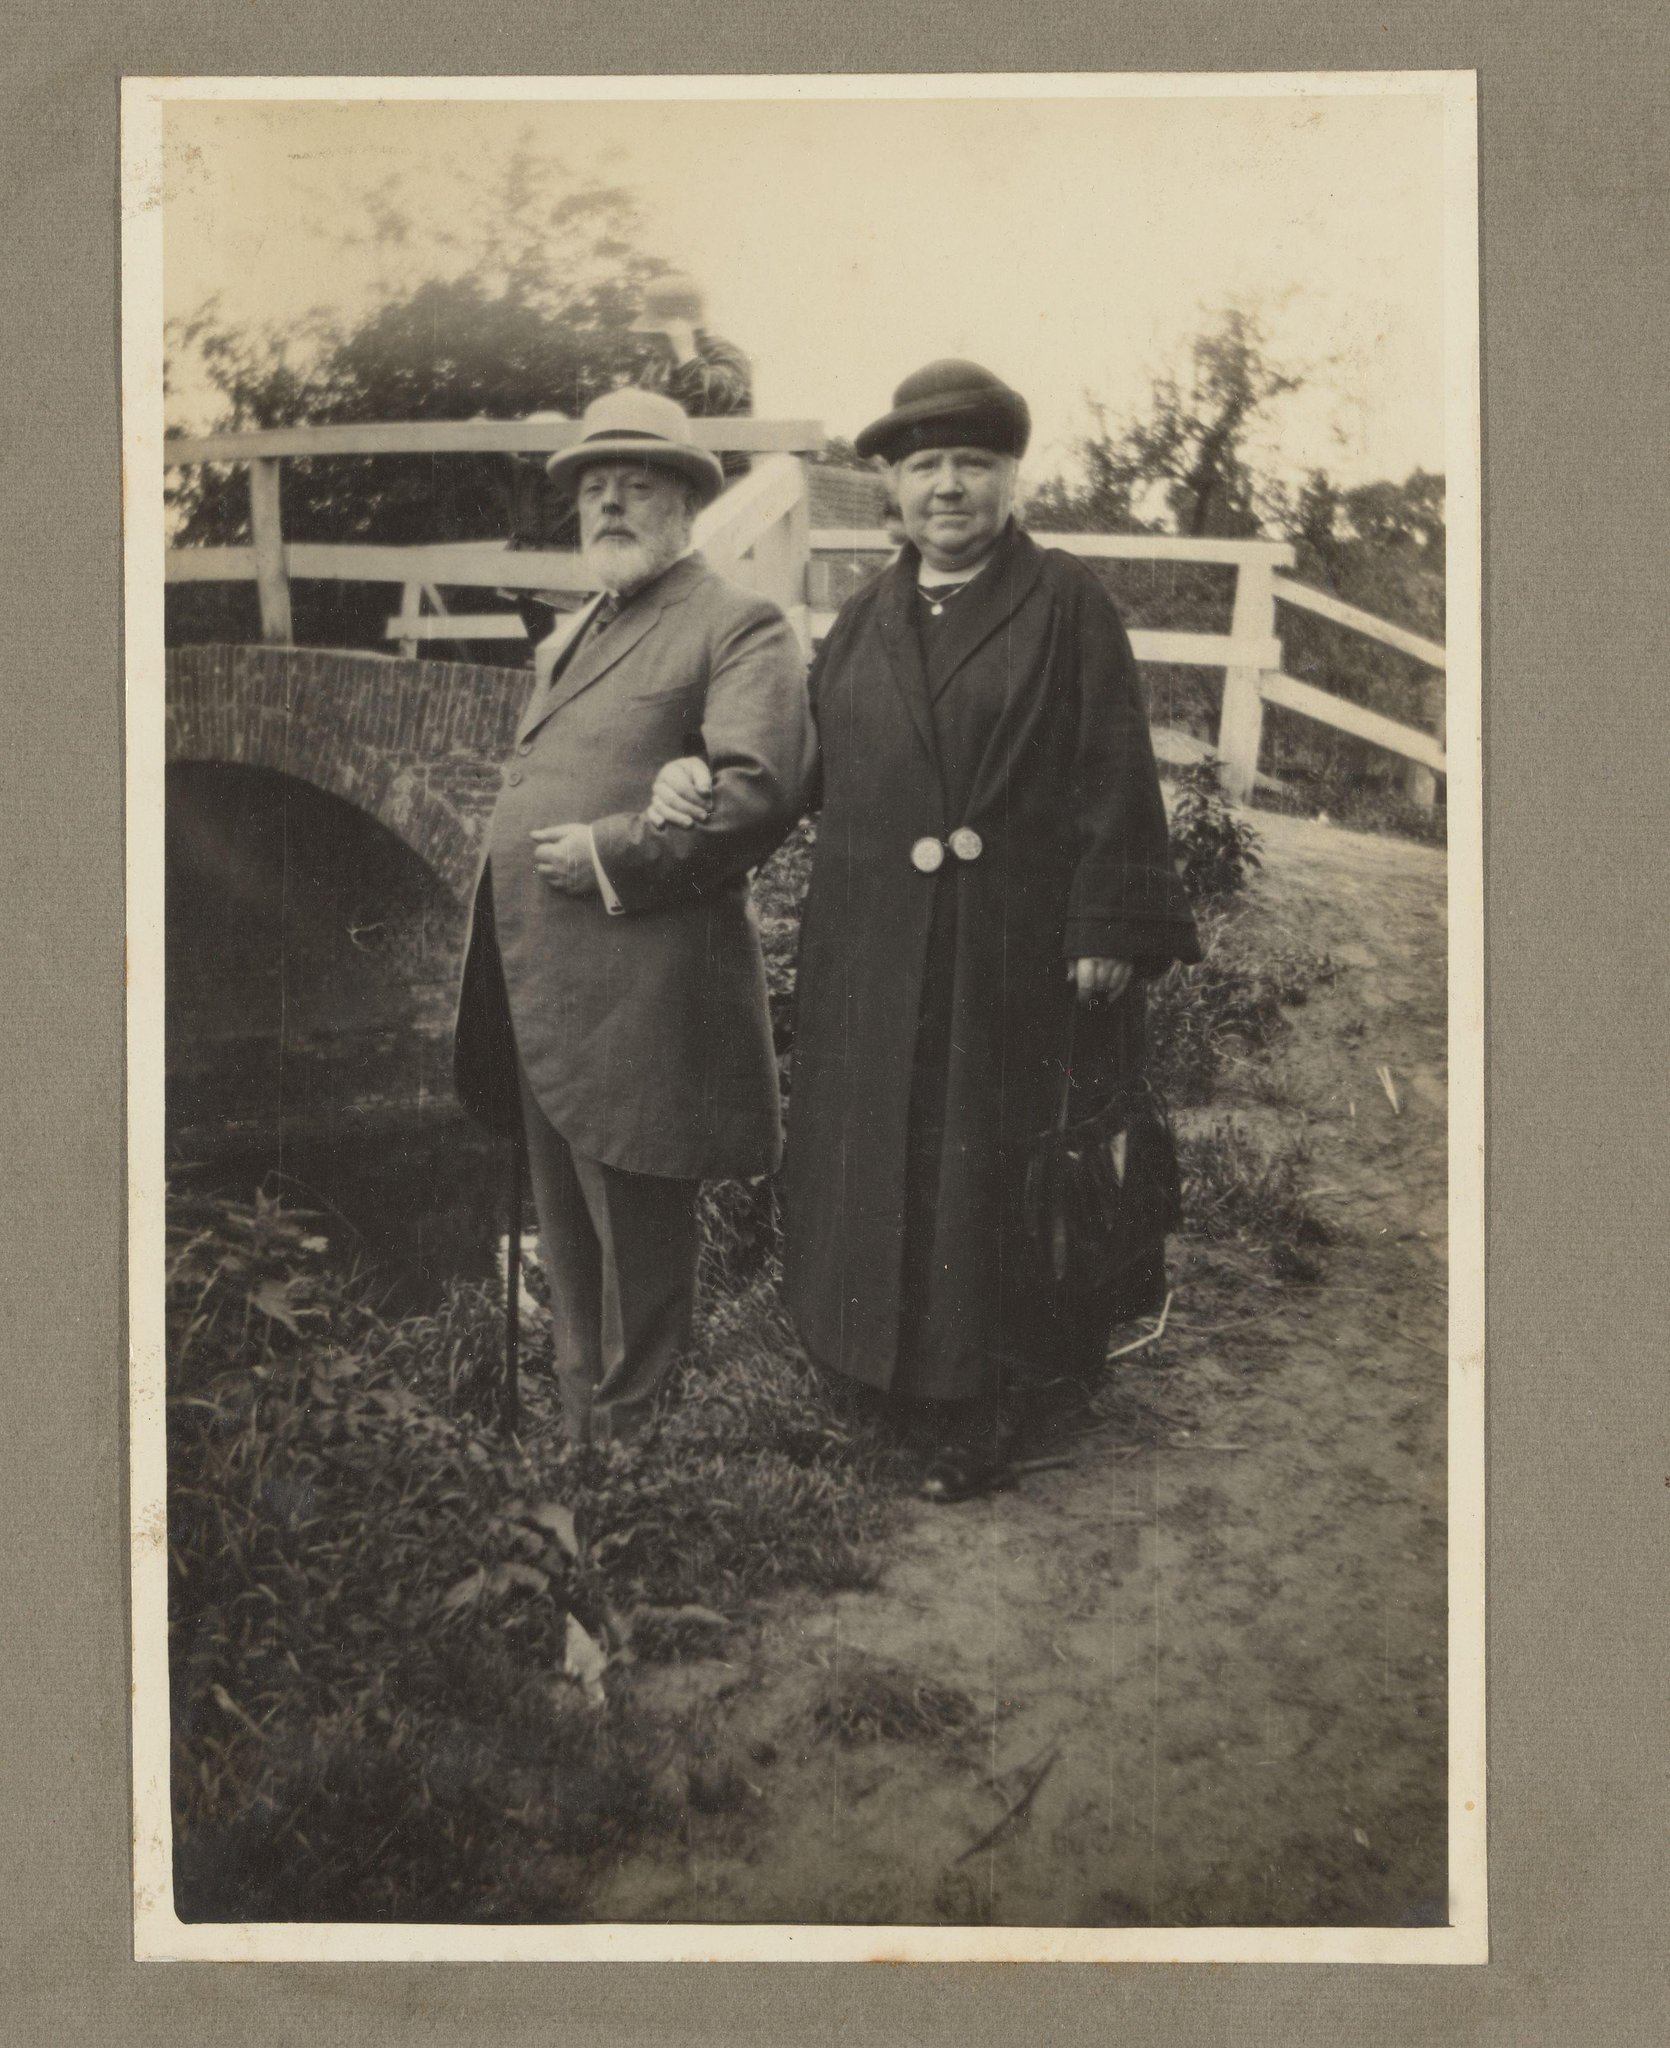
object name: photograph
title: Portret van een oudere man en vrouw bij een brug, vermoedelijk in Nederland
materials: cardboard, photographic support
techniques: gelatin silver print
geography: netherlands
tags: marriage, married couple, 'matrimonium', netherlands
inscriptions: name: ‘„Jacobs'" Fotobureau Joubertstraat 10 Amsterdam (oost)’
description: Onderdeel van Familiealbum met foto's van een familie in de voormalige kolonie Nederlands-Indië en van een suikerfabriek in Purworejo.